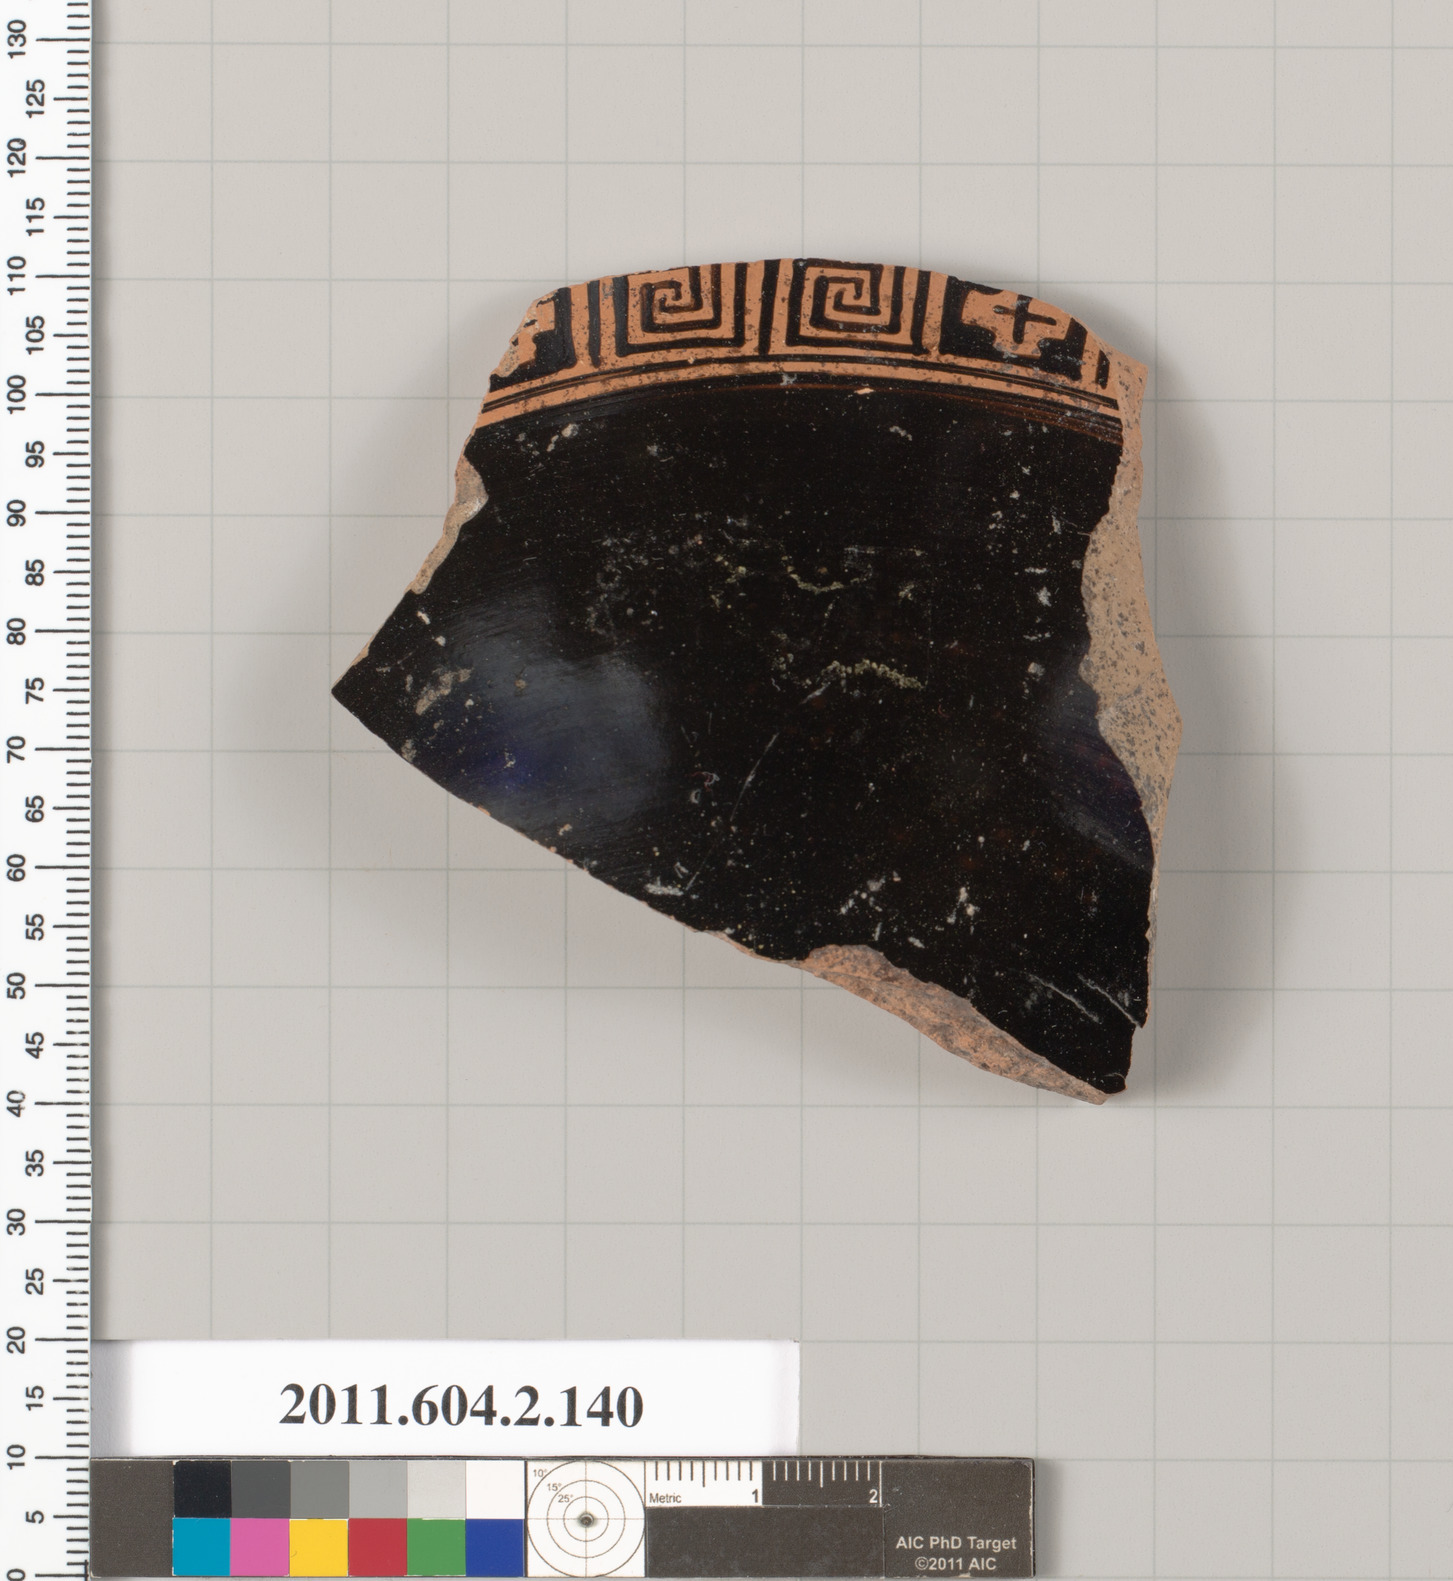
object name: pelike fragment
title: Terracotta fragment of a pelike (jar)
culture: greek, attic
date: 510-490 BCE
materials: terracotta